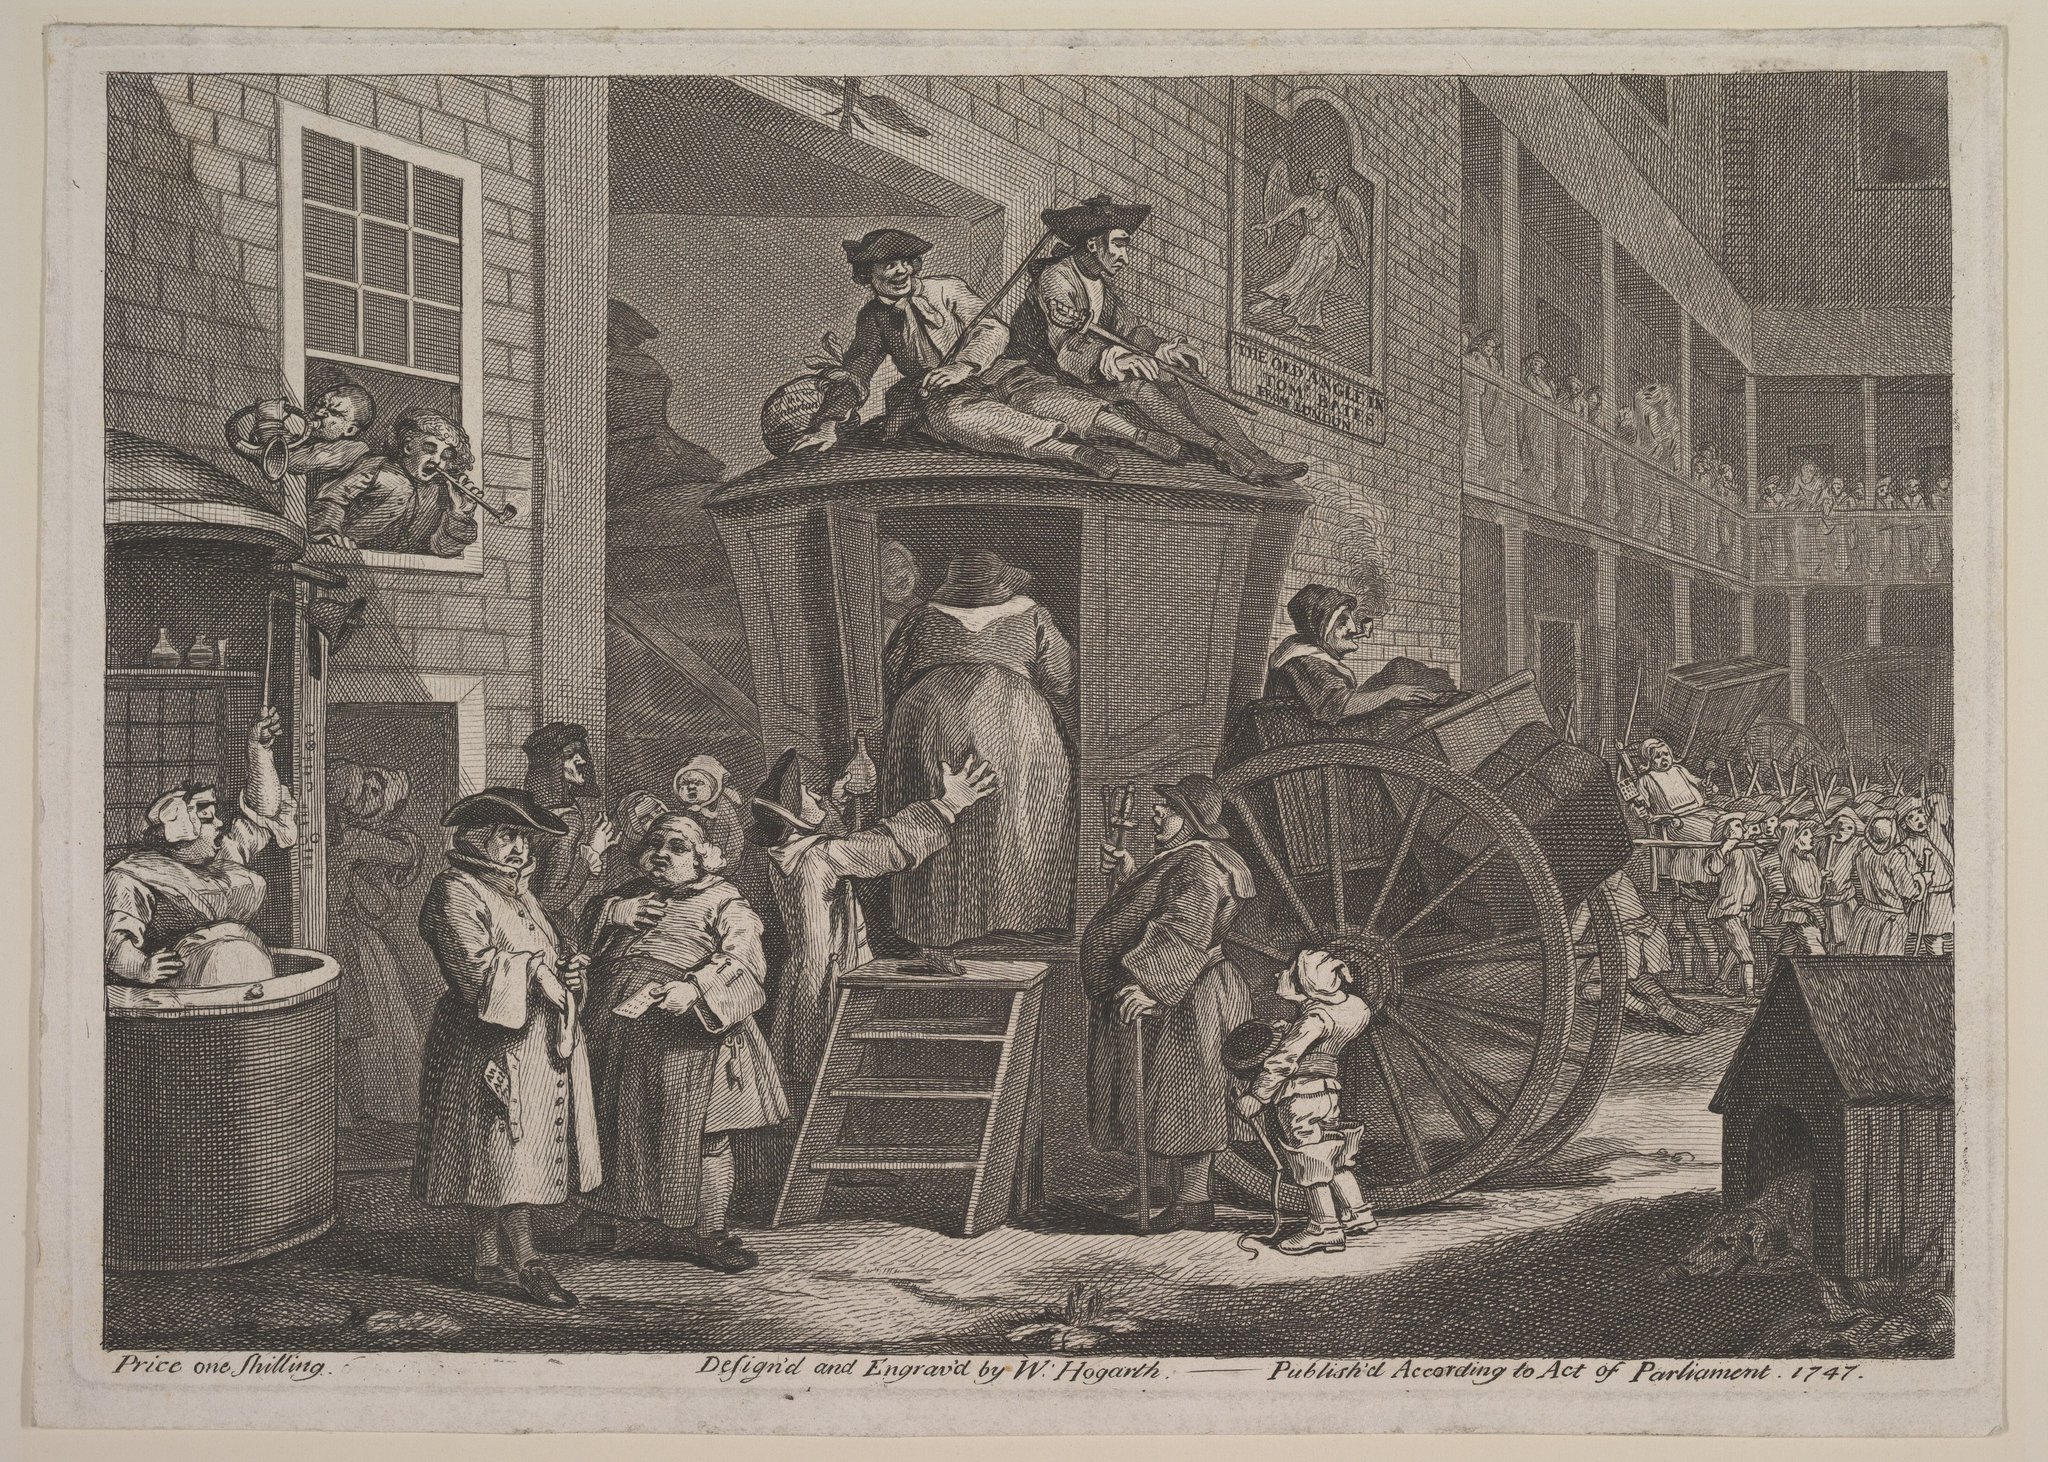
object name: print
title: The Stage Coach, or Country Inn Yard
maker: william hogarth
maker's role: artist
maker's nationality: british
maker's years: 1697-1764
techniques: engraving, etching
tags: buildings,men,women,crowd,carriages